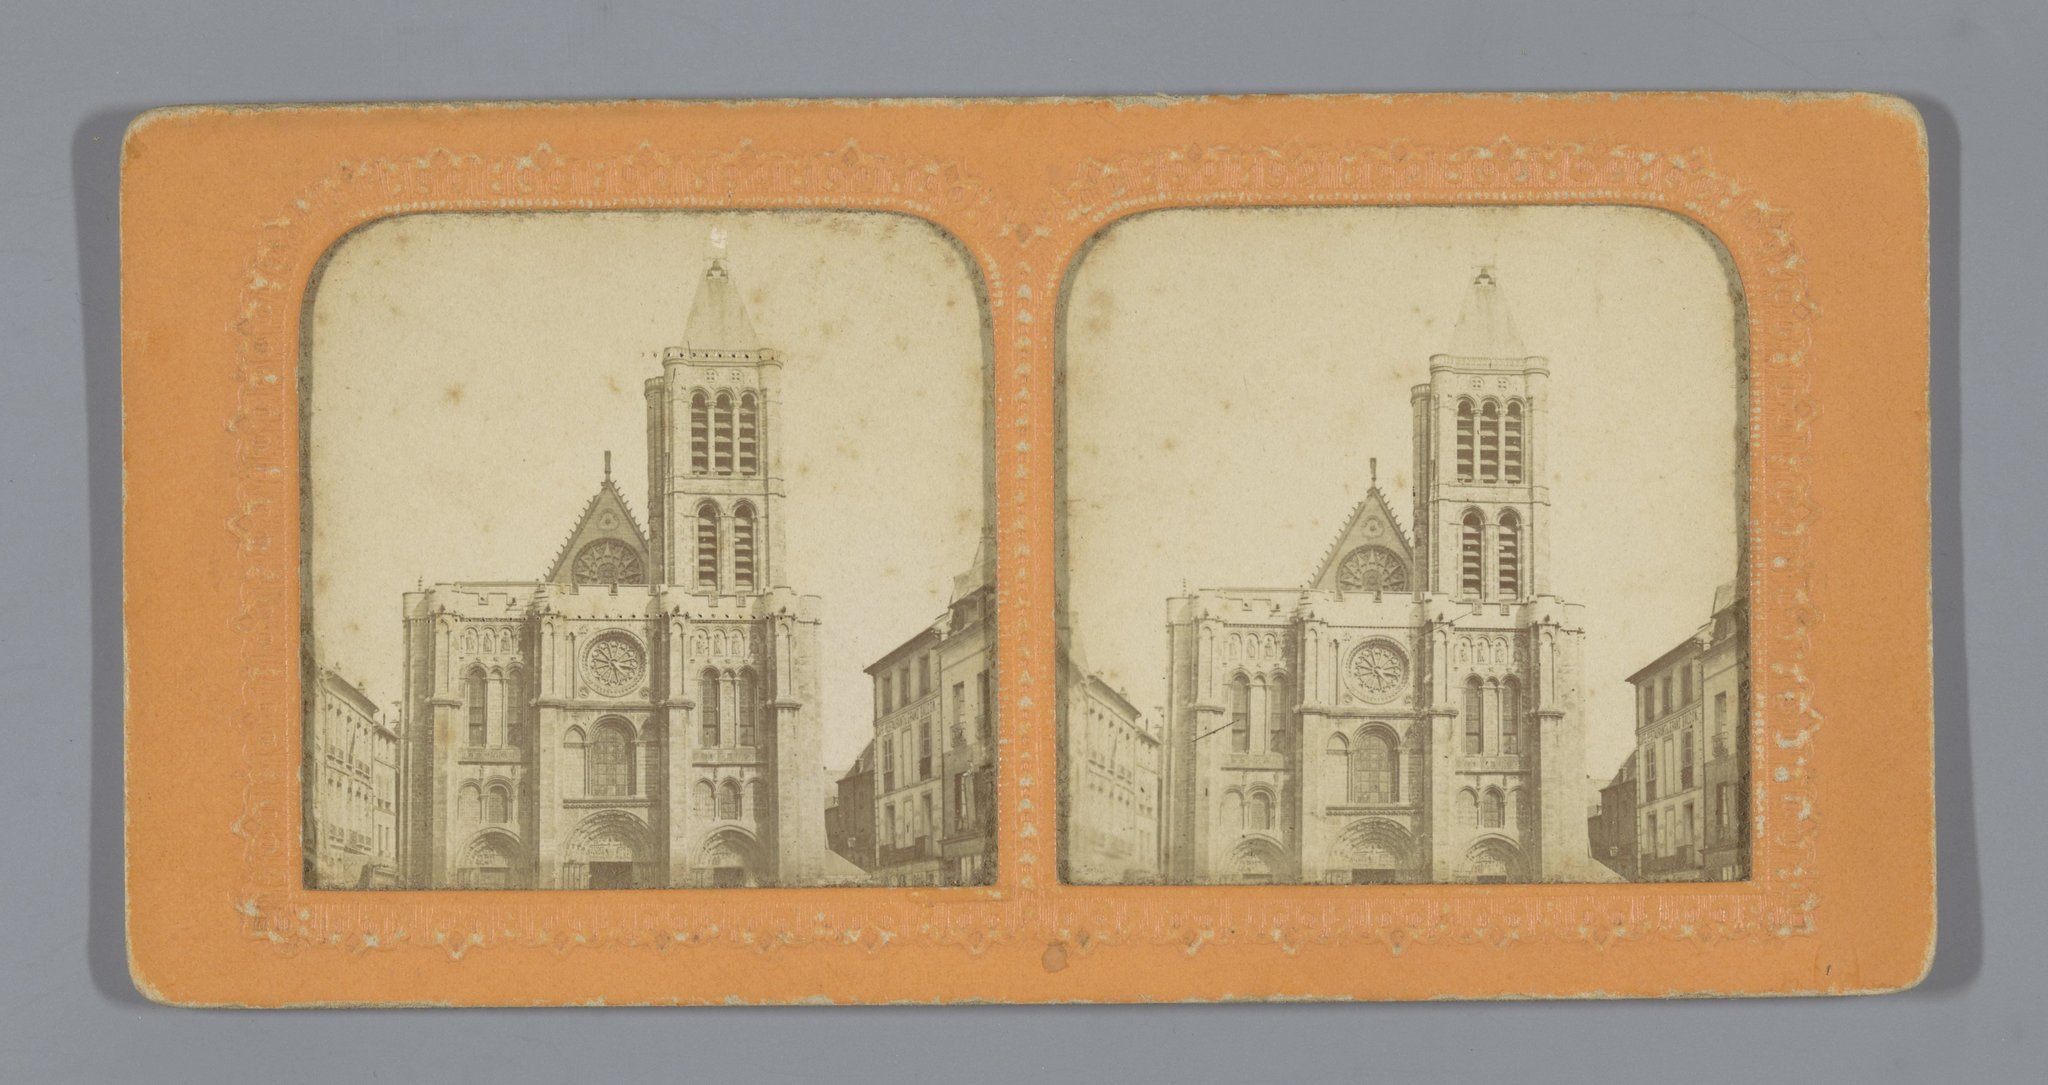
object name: tissue stereograph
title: Exterieur van de Saint-Denisbasiliek nabij Parijs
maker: Anonymous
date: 1855-1875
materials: cardboard, paper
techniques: albumen print, hand coloring, perforating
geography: paris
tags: church (exterior)